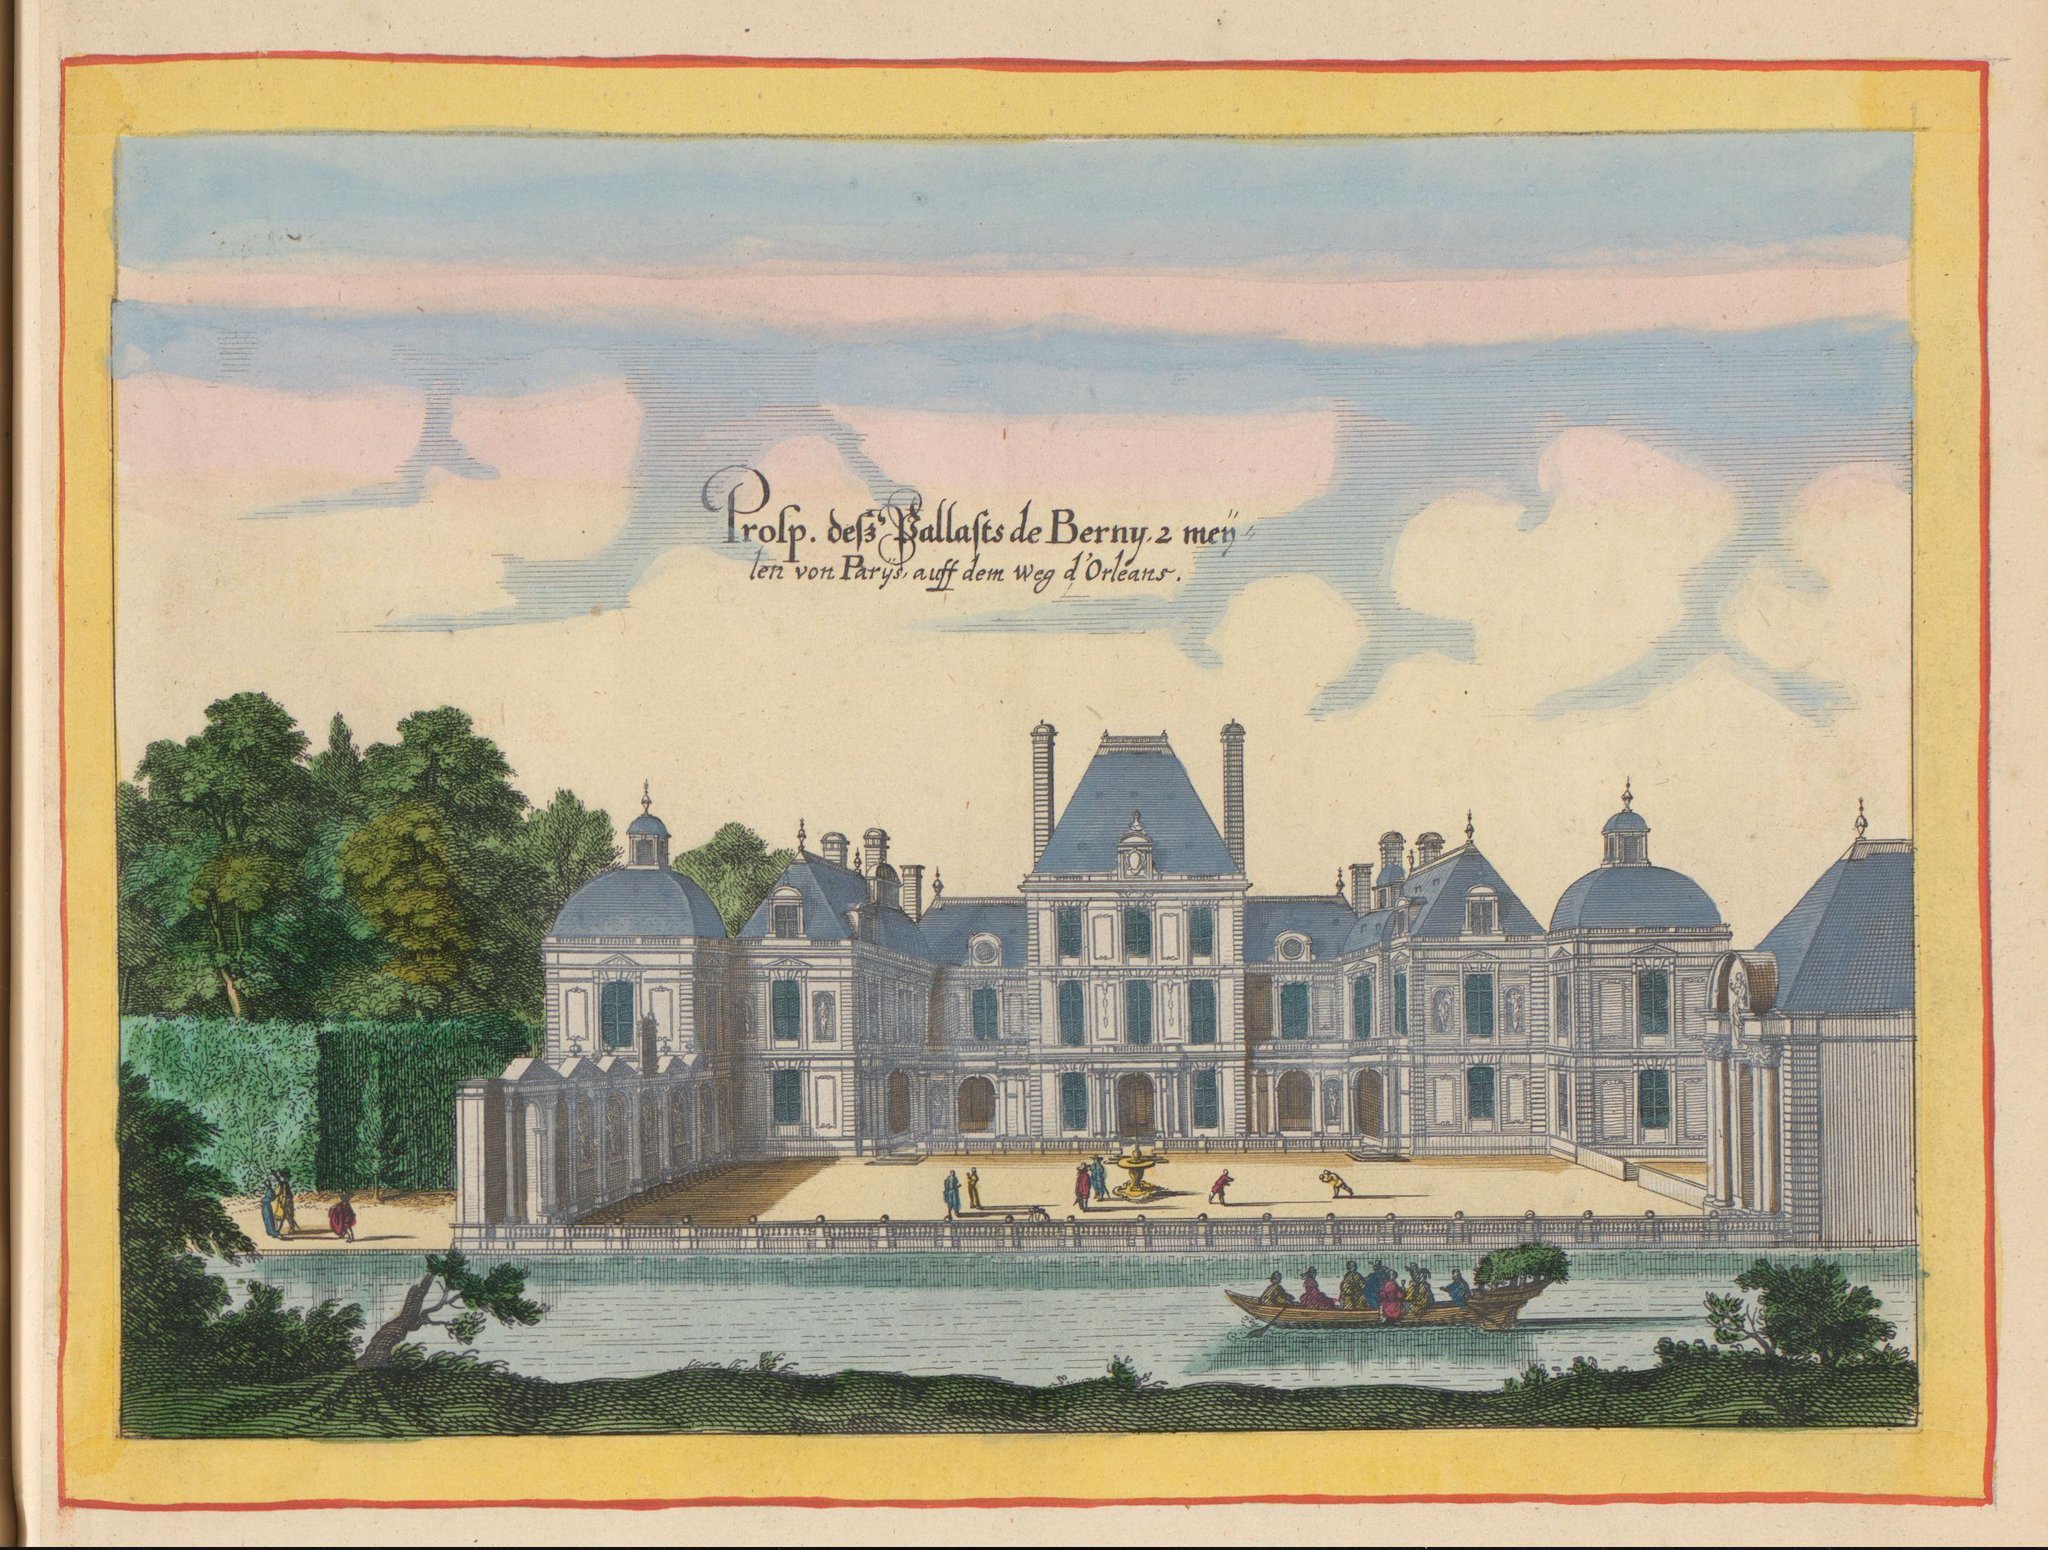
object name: album leaf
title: Gezicht op Château de Berny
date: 1655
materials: paper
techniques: engraving, etching, hand coloring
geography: frankfurt am main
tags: castle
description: Prent origineel vervaardigd als boekillustratie voor: Zeiller, Martin. Topographia Galliae, oder Beschreibung und Contrafaitung der vornehmbsten und bekantisten Oerter in dem mächtigen und grossen Königreich Frankreich, 13 delen. Frankfurt am Main: Caspar Merian, 1655-1661. De prent werd voor het eerst gepubliceerd in deel 1: Topographia Galliae, 1655. De prent is langs de bovenrand van de voorstelling afgescheurd. De voorstelling is aan de bovenzijde aangevuld met een geschilderde lucht.